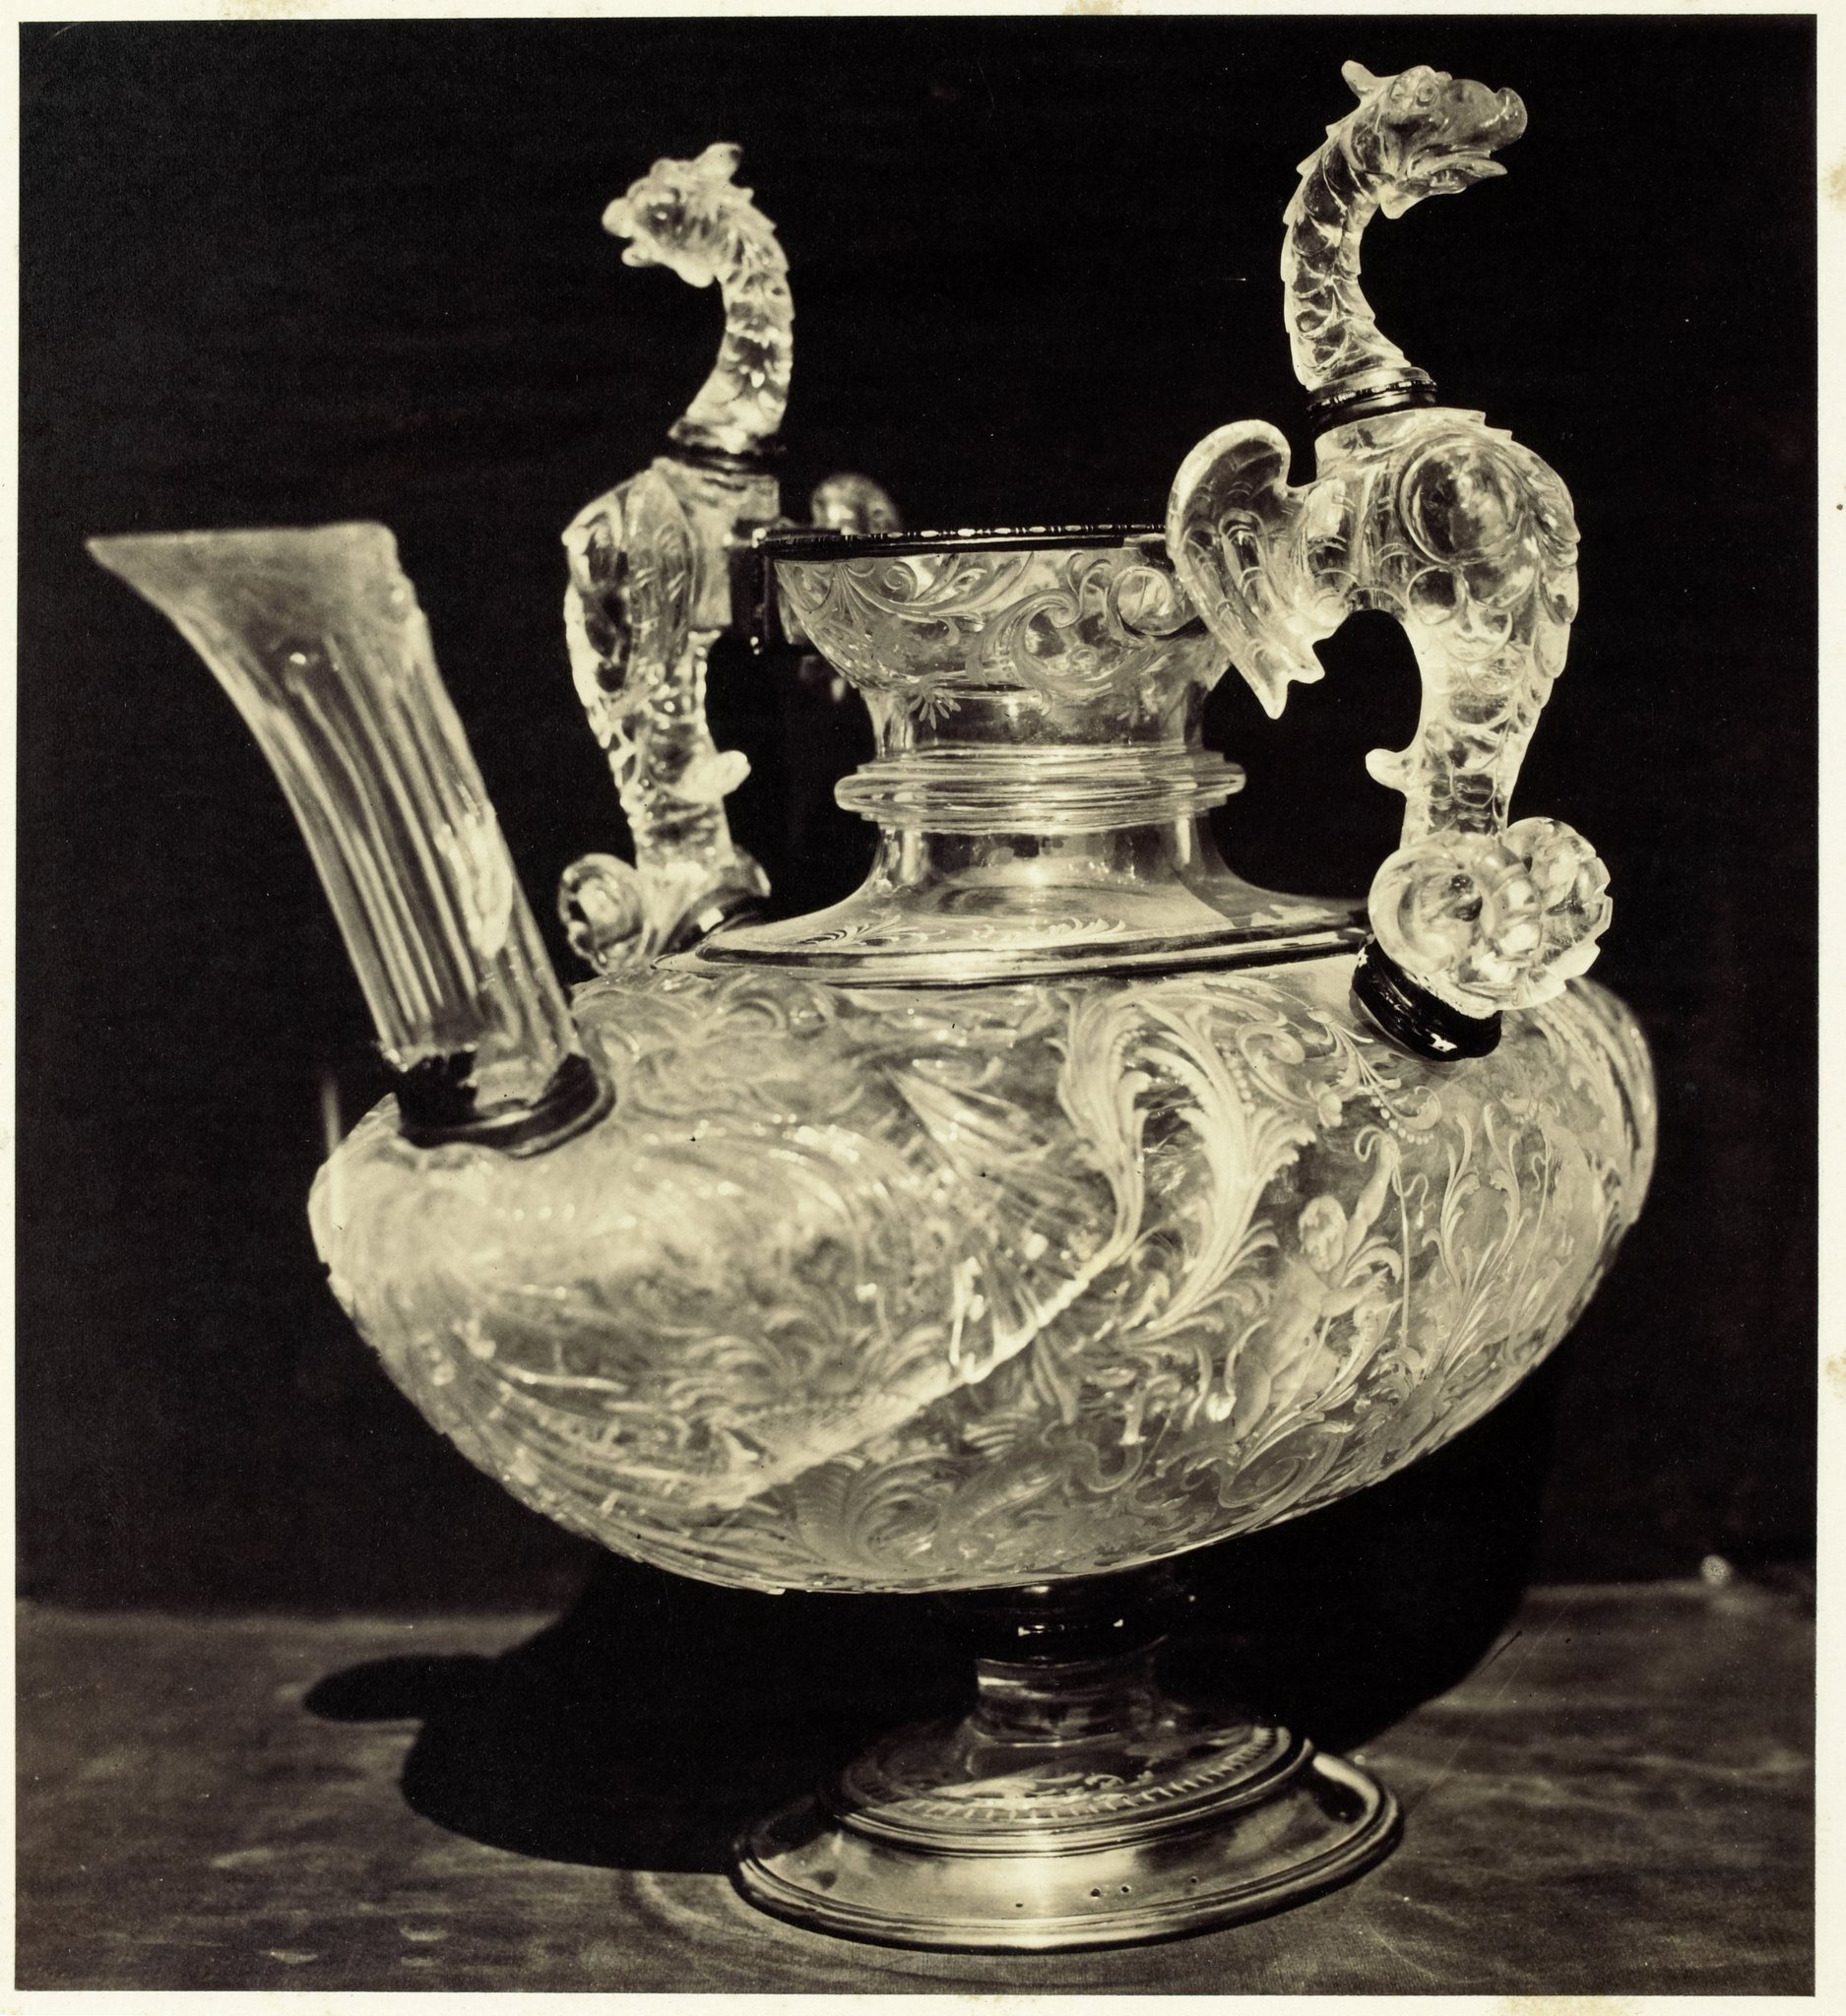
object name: photomechanical print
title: Kristallen gegraveerde schenkkan met handvaten in de vorm van draken, uit het Louvre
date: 1866-1890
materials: paper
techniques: woodburytype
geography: louvre museum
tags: container of glass: bottle, jar, vase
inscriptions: inscription: ‘Photographed by C. Thurston Thompson.’